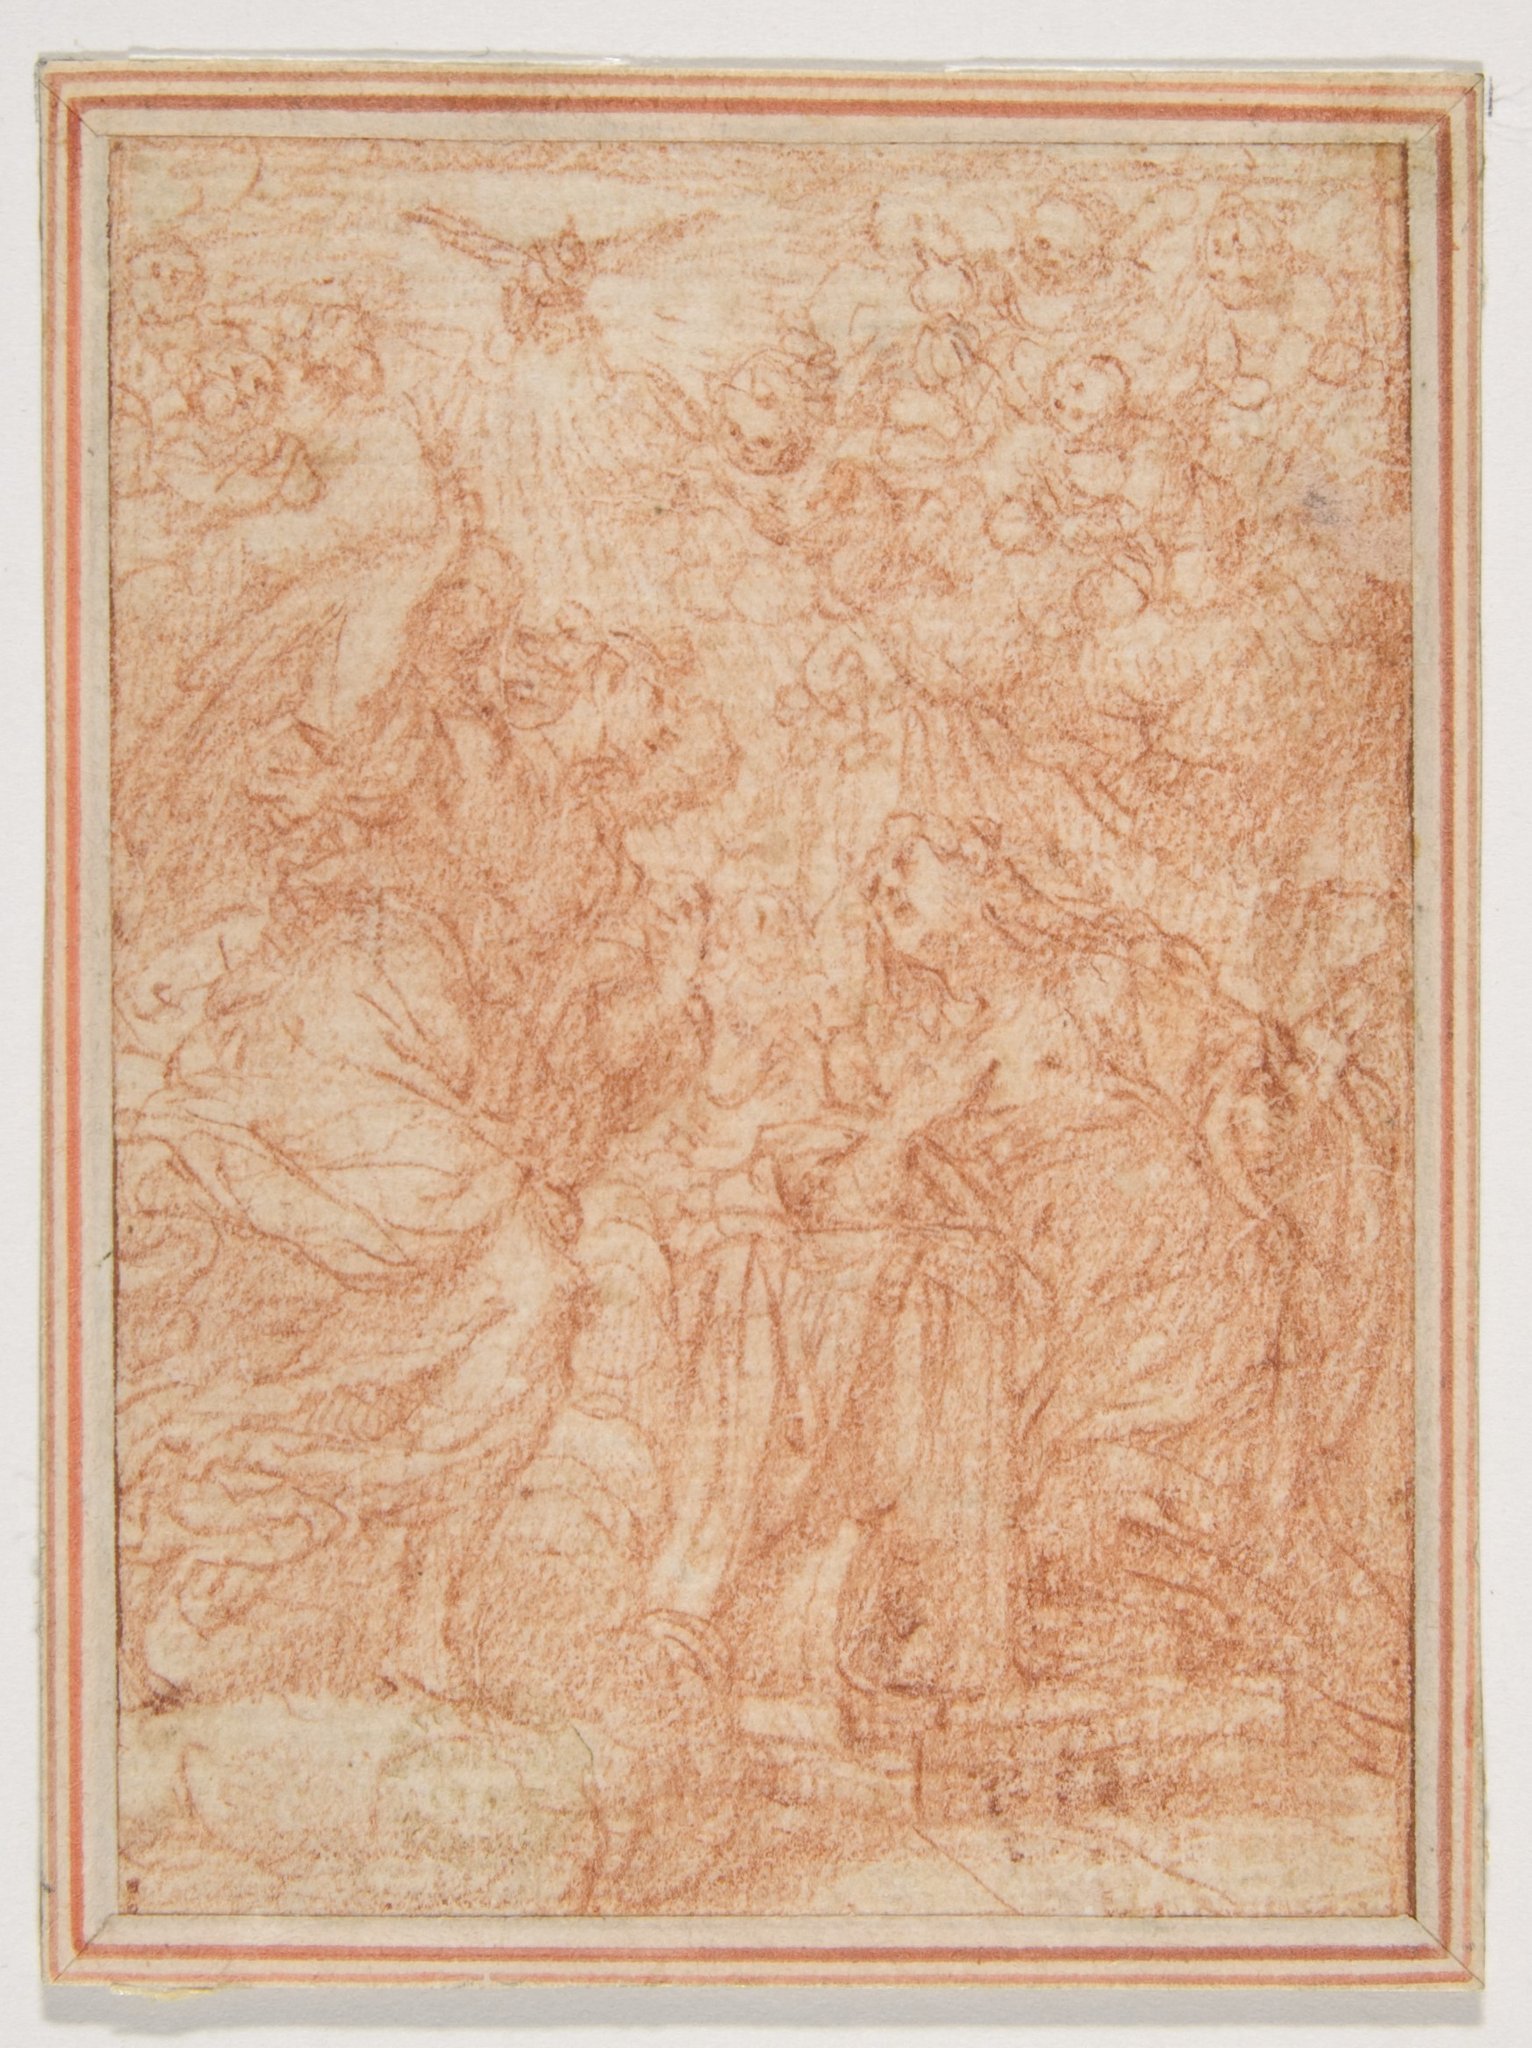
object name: drawing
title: The Annunciation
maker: camillo procaccini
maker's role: artist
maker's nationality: italian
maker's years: 1555-1629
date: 1616-1618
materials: chalk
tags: angels,virgin mary,annunciation